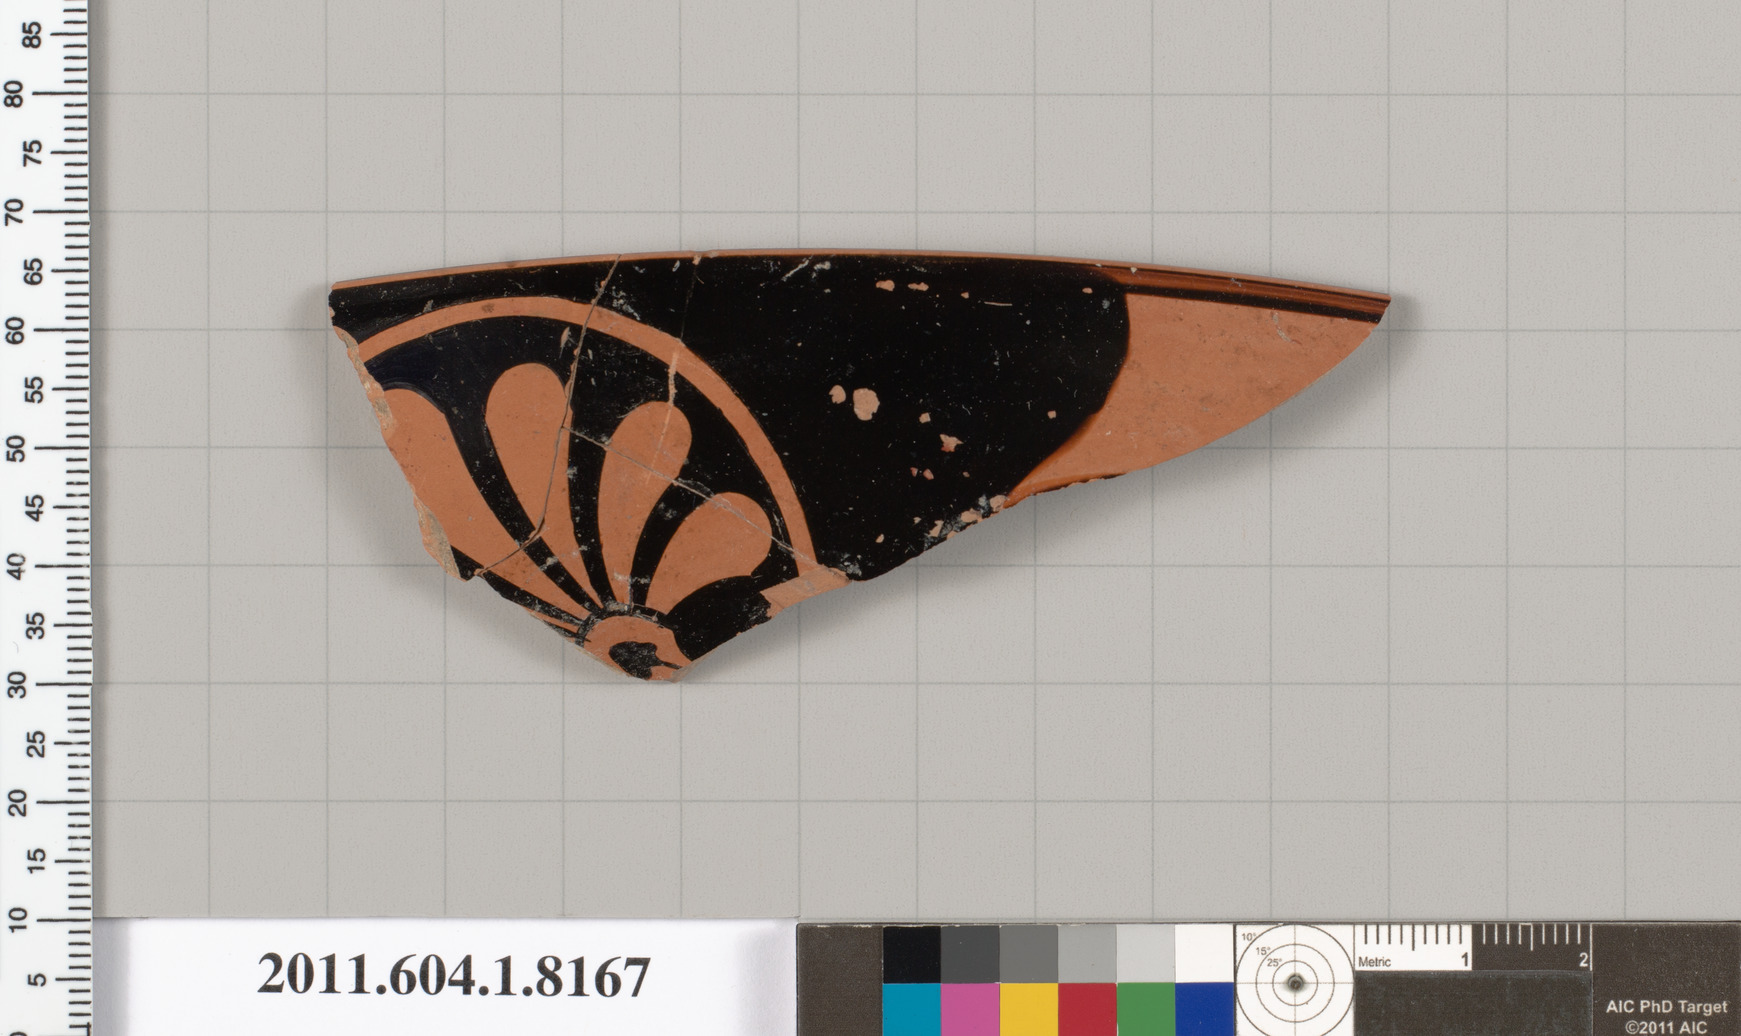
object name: kylix fragment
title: Terracotta rim fragment of a kylix (drinking cup)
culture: greek, attic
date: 520-510 BCE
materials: terracotta